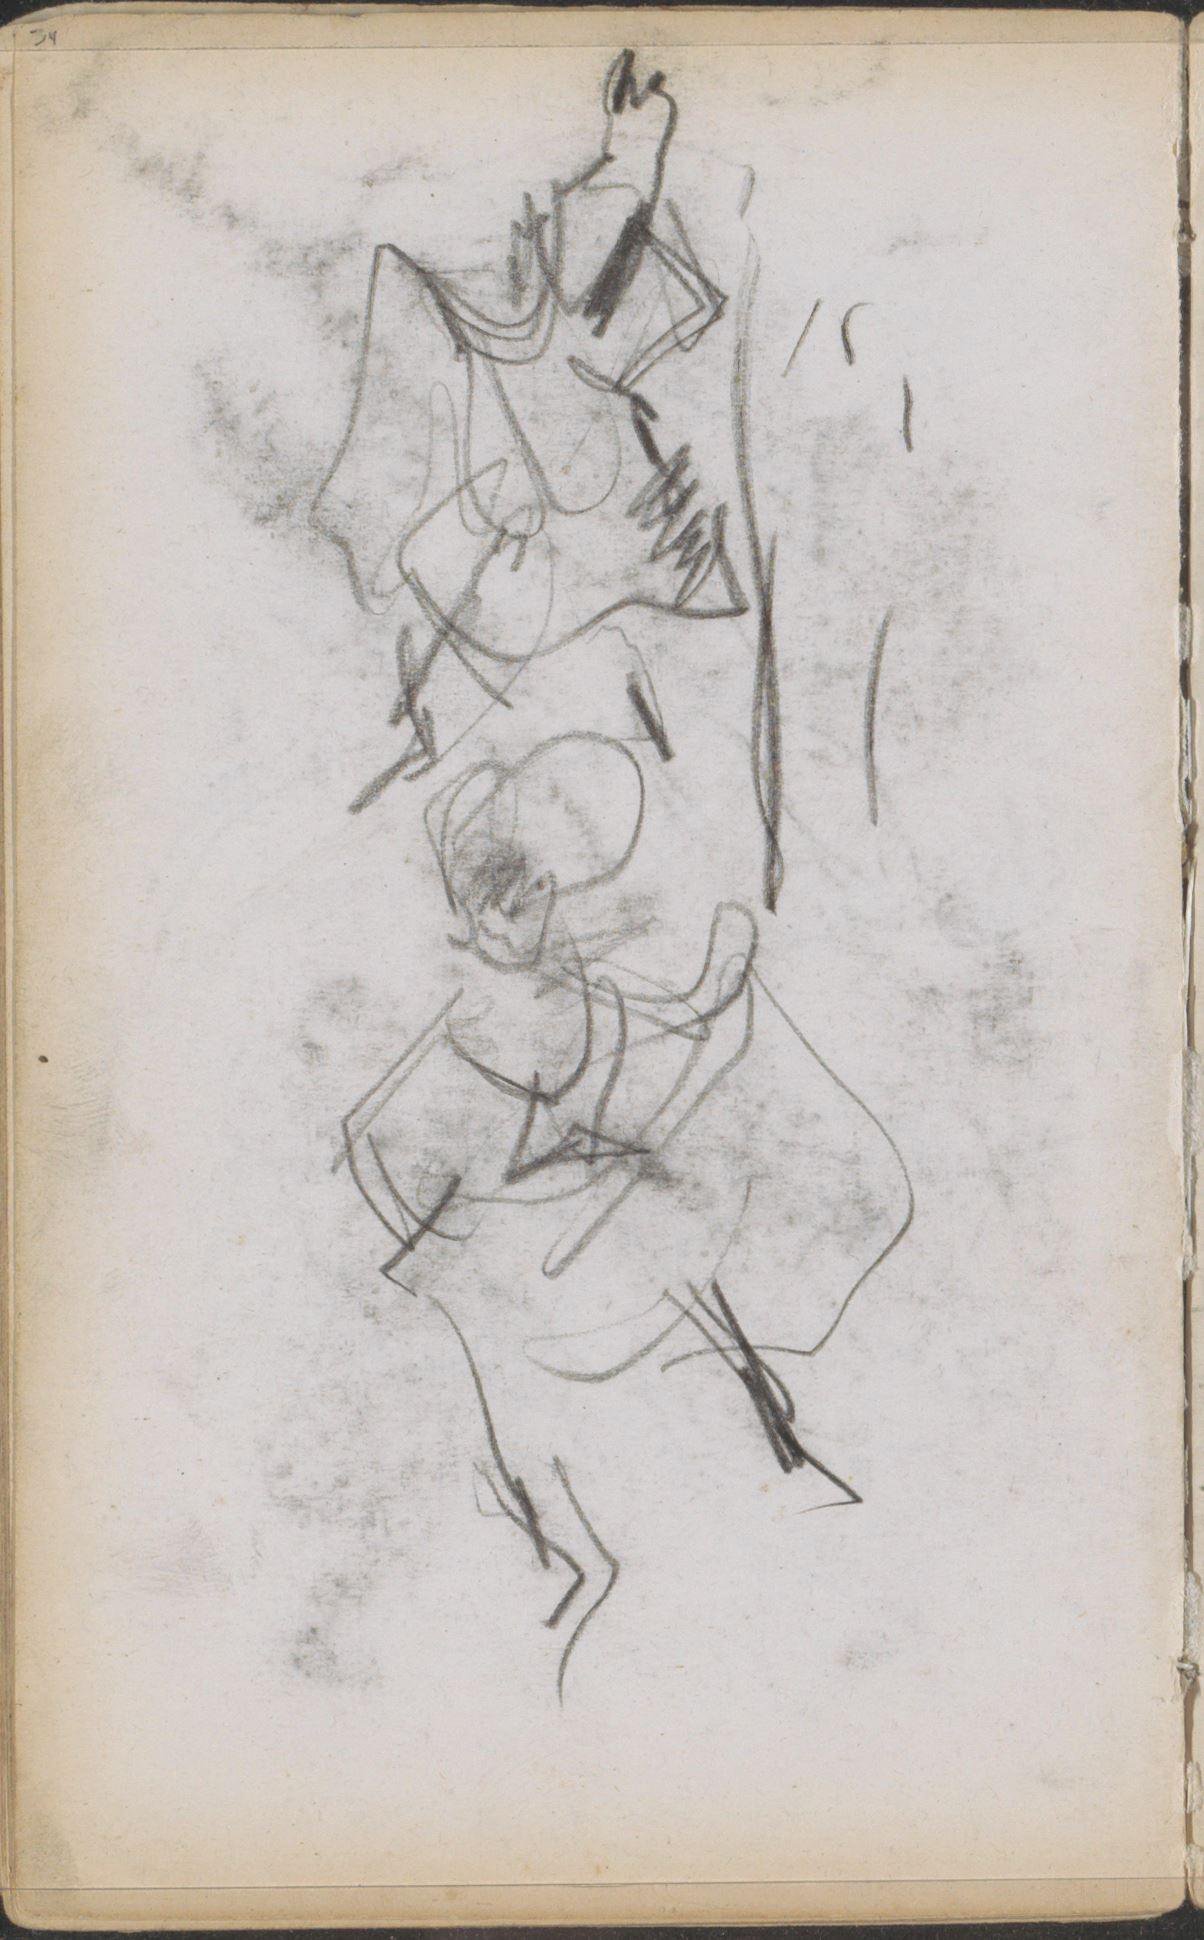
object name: sketchbook leaf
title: Danseressen in de Moulin Rouge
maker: marius bauer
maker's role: draughtsman, print maker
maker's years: 1867-1932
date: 1810-1891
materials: chalk, paper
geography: paris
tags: female dancer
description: De vrouwen tillen hun rok omhoog. Vermoedelijk dansen ze de cancan. Pagina 34 uit een schetsboek met 35 bladen.